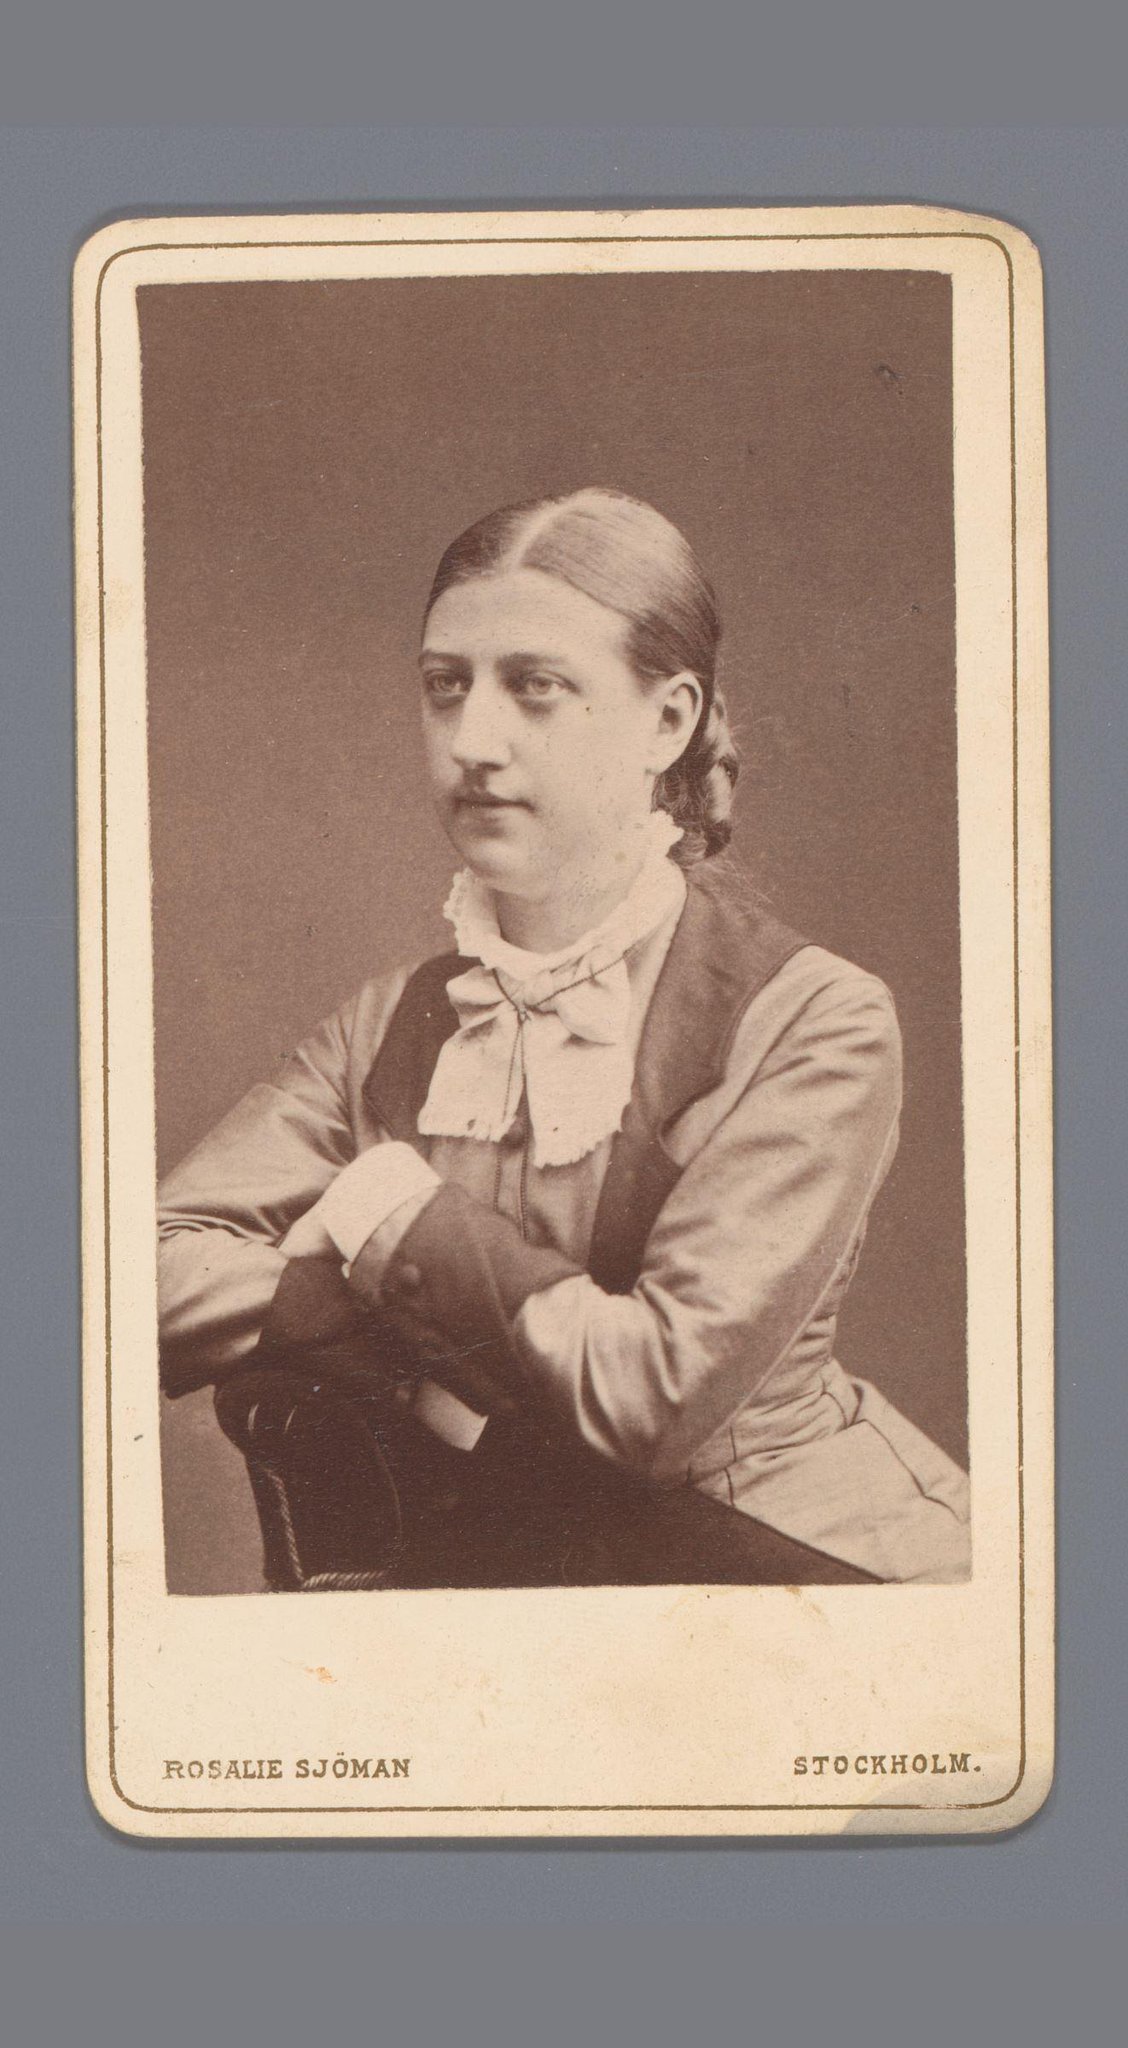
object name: photograph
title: Portret van een onbekende zittende vrouw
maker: rosalie sophie sjöman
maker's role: fotograaf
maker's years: 1833-1919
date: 1864-1882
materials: cardboard, paper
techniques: albumen print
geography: stockholm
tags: historical persons - bb - woman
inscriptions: inscription: ‘Rosalie Sjöman/ Fotografi Atelier/ STOCKHOLM/ 42 Drottninggatan 42/ öfver gården 2 tr. upp./ Plåten bevaras för efterbeställning.’